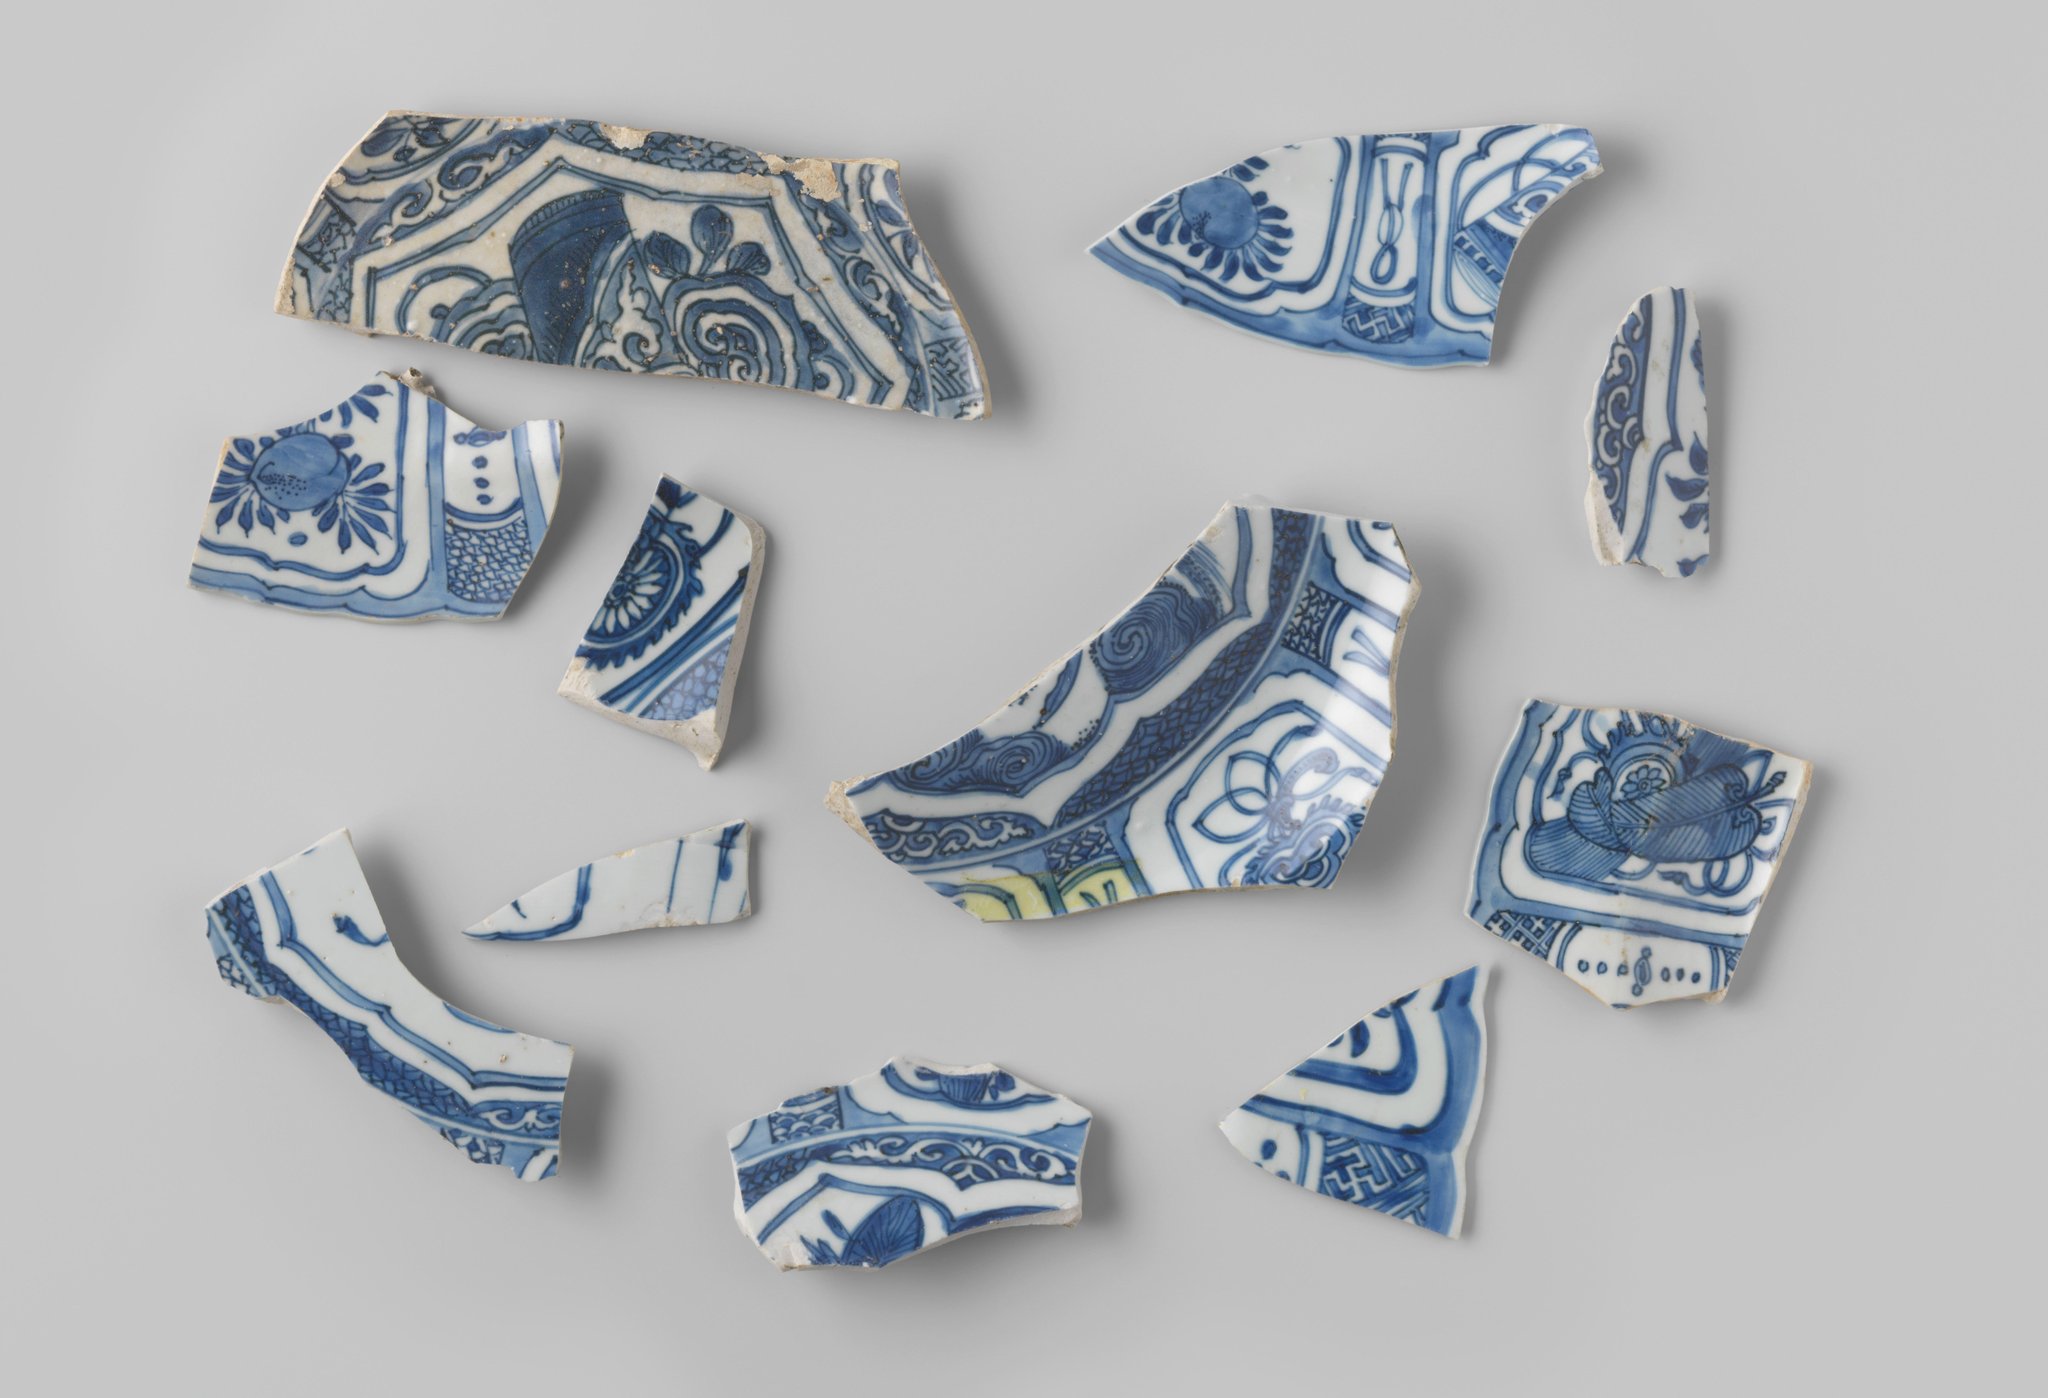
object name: sherd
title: Scherven uit V.O.C.-schip de 'Witte Leeuw'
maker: Anonymous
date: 1613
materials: bone china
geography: jingdezhen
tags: verenigde oostindische compagnie, sint-helena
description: Scherven uit V.O.C.-schip de 'Witte Leeuw'.